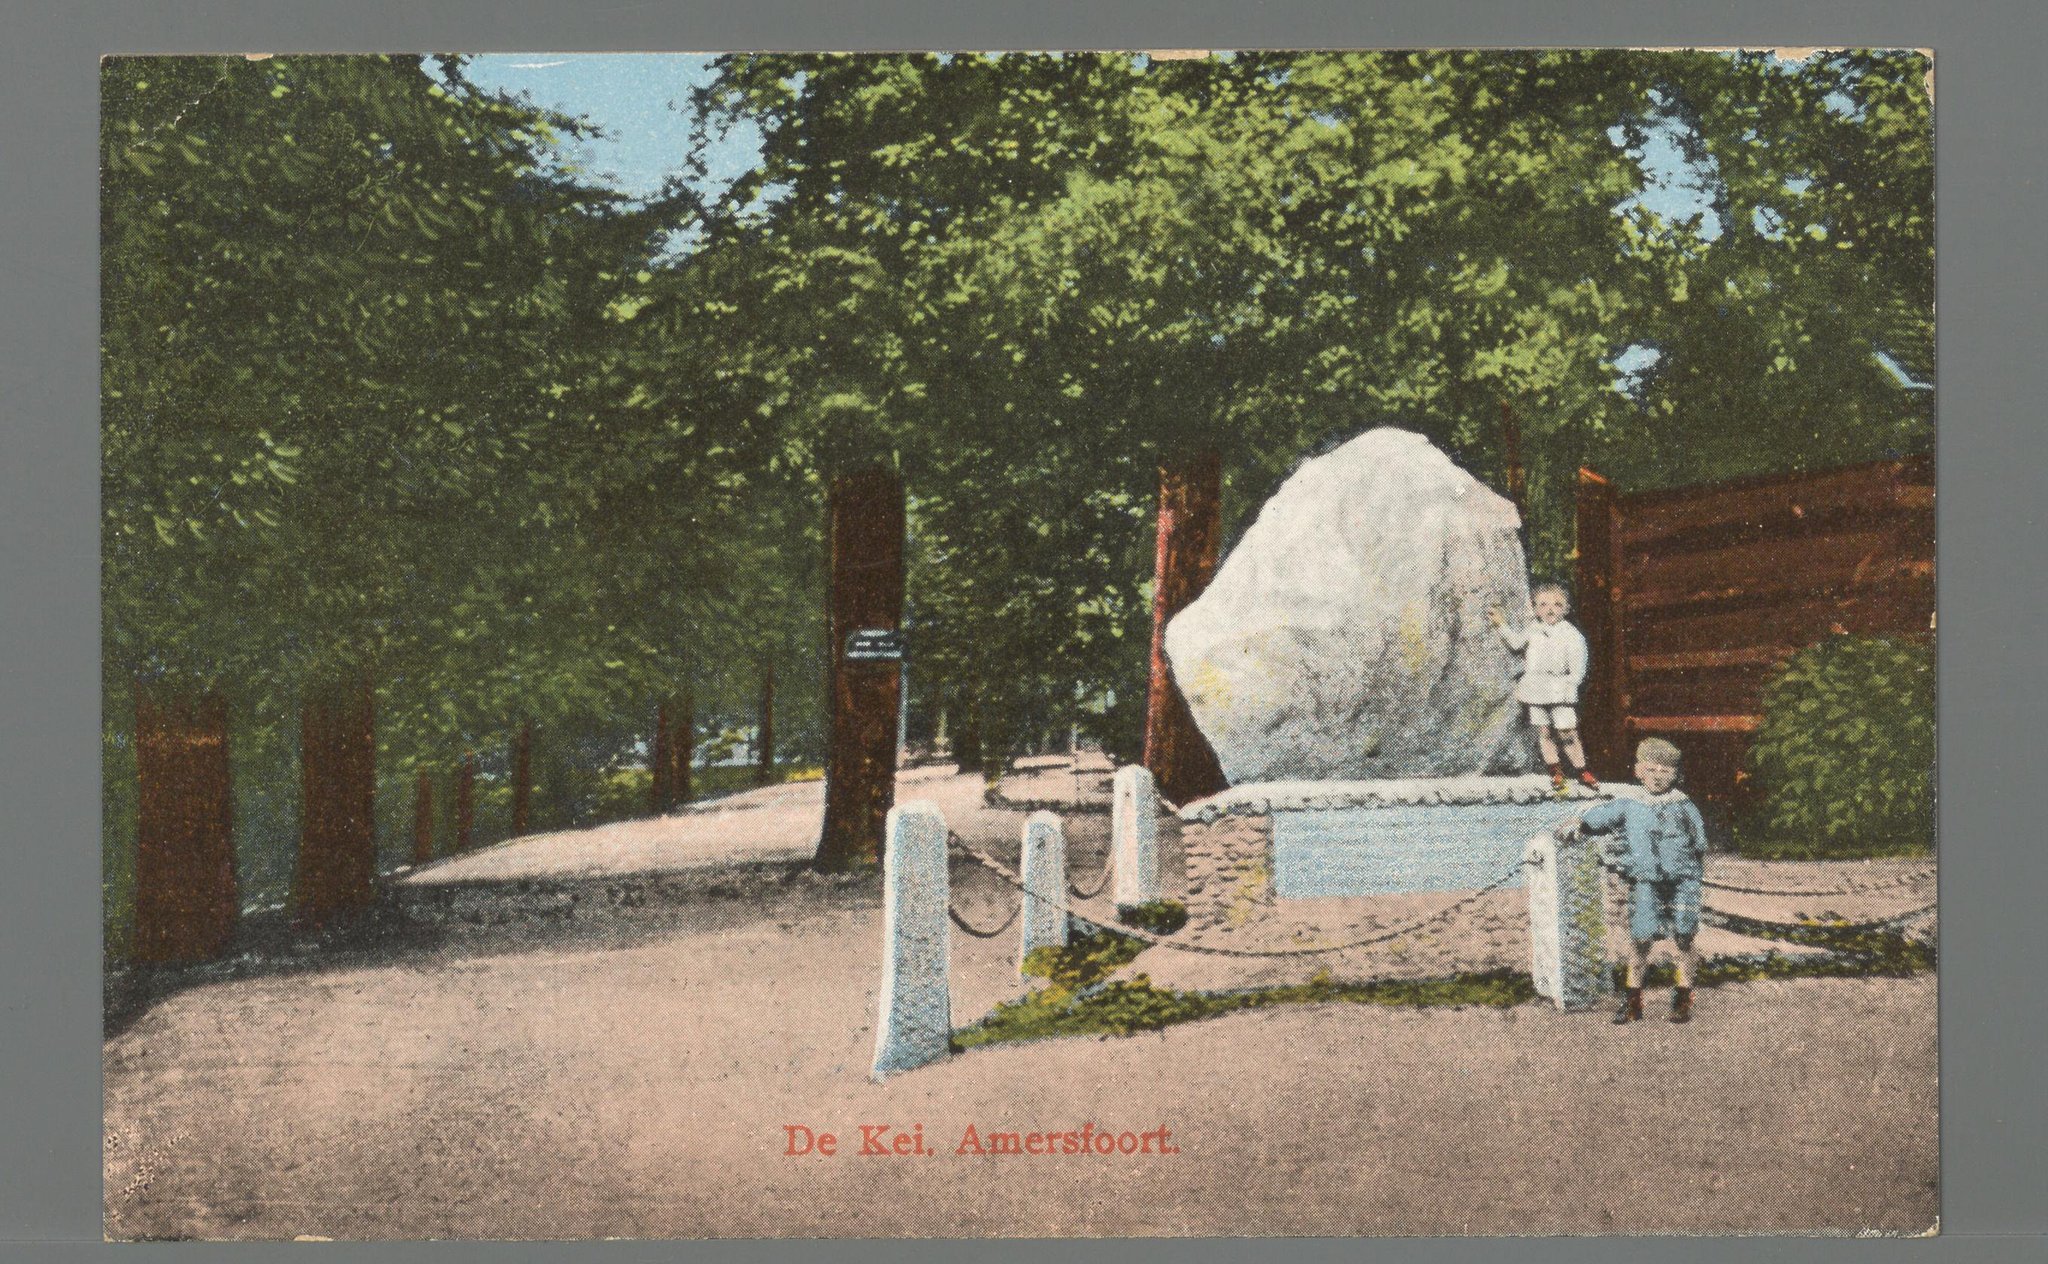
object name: photomechanical print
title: De Kei, Amersfoort.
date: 1905-1931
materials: cardboard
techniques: lithograph, writing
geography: amersfoort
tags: monument, statue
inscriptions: postage stamp